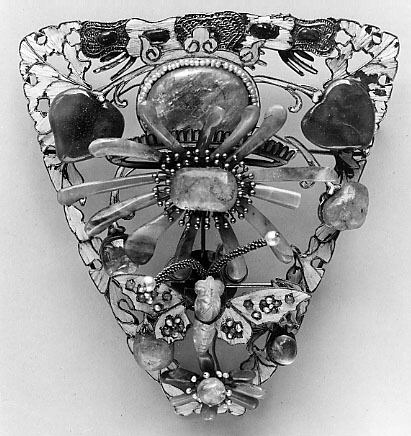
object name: ornament for manzhu hat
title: Ornaments for Manzhu Hat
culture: chinese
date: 1701-1800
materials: coral, feather, glass, jade, metal, pearl, gemstone